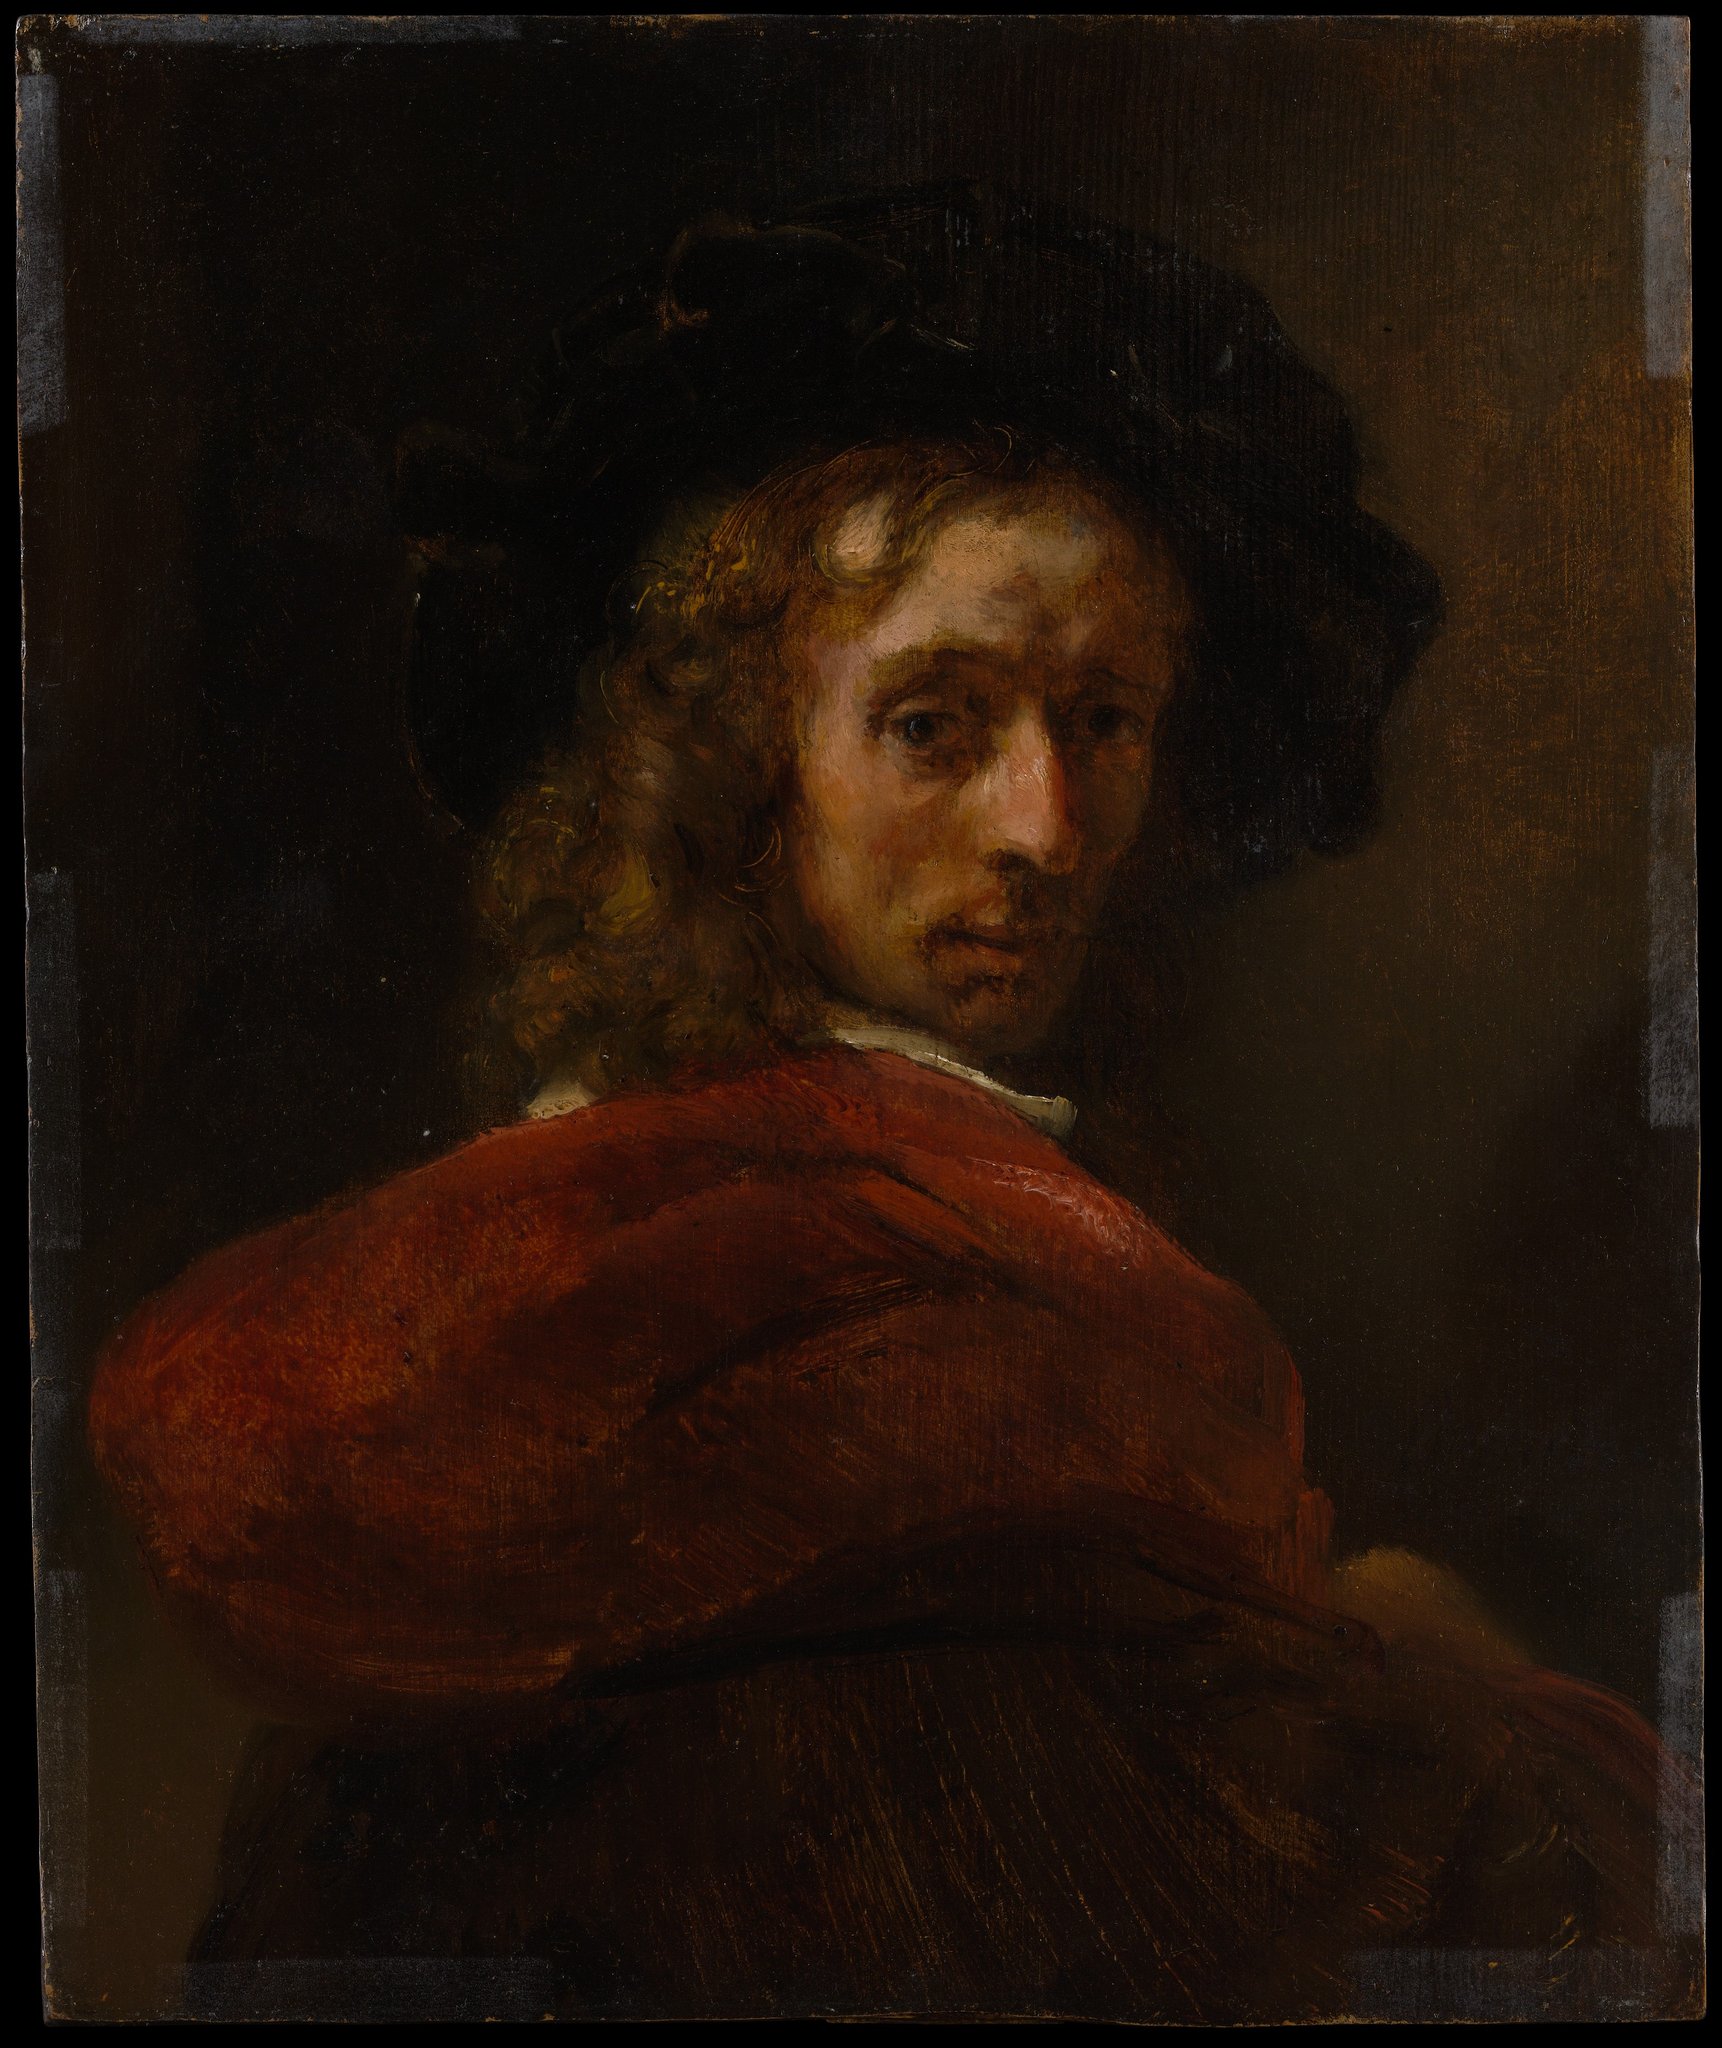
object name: painting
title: Man in a Red Cloak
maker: rembrandt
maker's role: artist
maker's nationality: dutch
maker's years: 1606-1669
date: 1625-1674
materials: oil, wood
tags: men,portraits